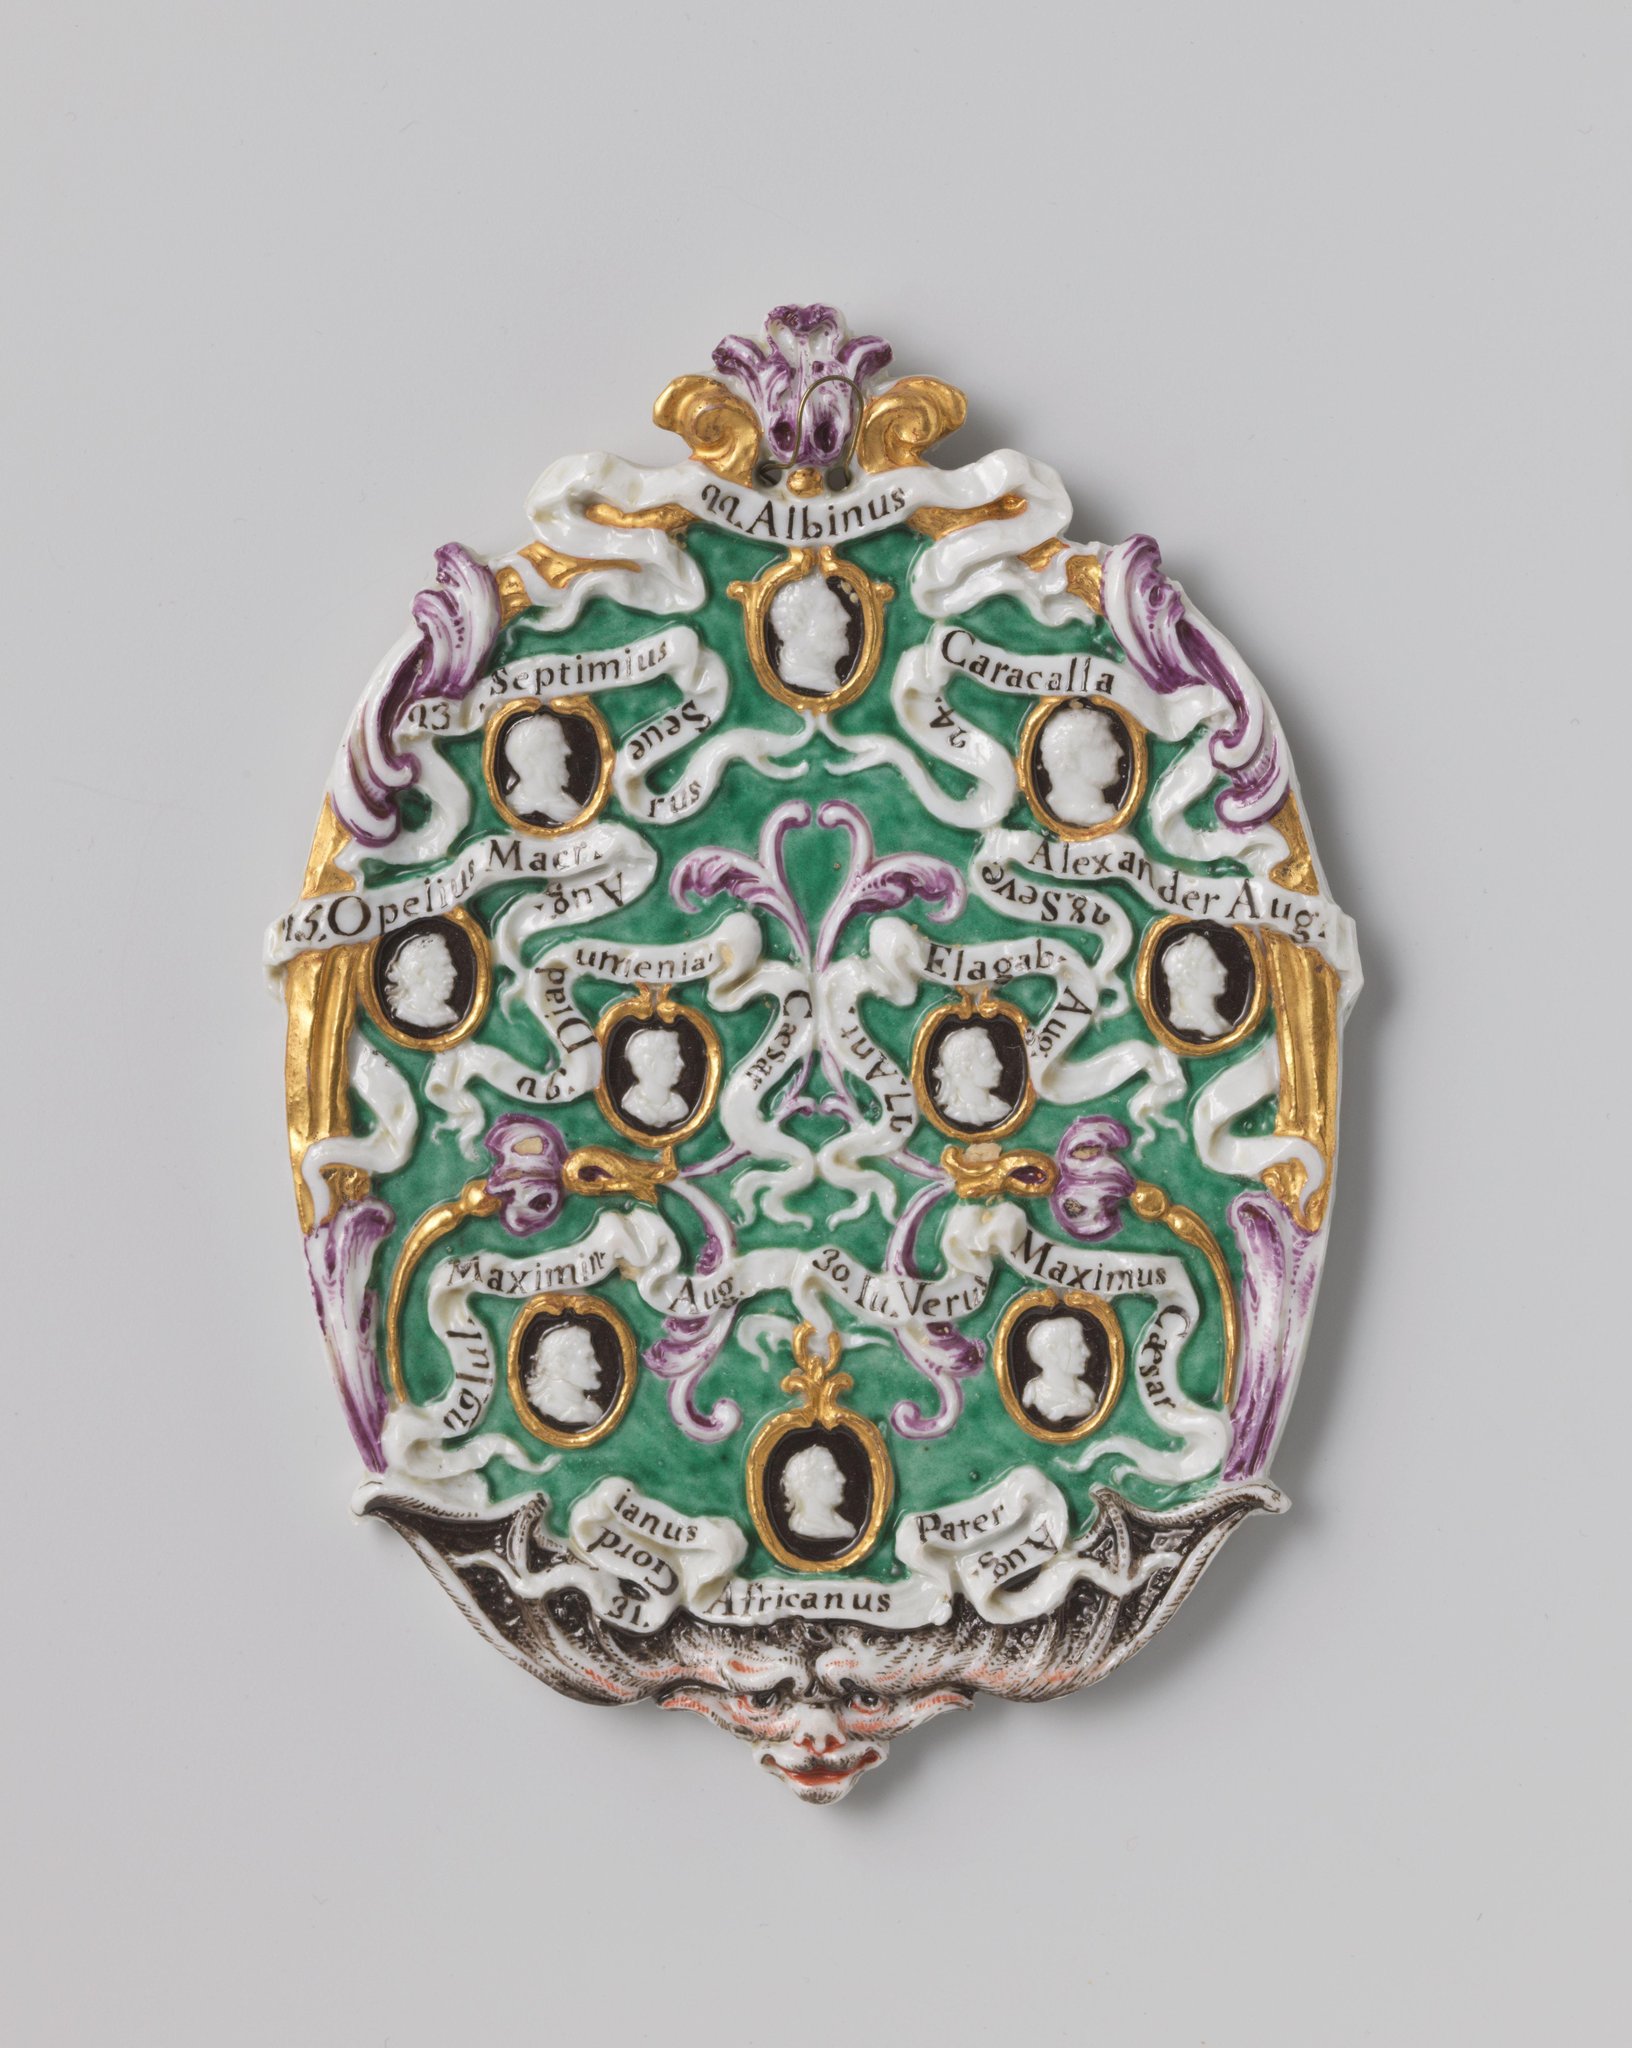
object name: plate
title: Plaque with the portraits of Roman emperors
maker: anton filippo weber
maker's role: modelleur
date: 1749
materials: glaze, gold, paint, porcelain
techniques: firing, forming, gilding, vitrification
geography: doccia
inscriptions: mark: ‘3’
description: Two plaques with portraits of Roman emperors. Porcelain. Doccia (Italy), c. 1749, factory of Carlo Ginori, model by Anton Filippo Weber.